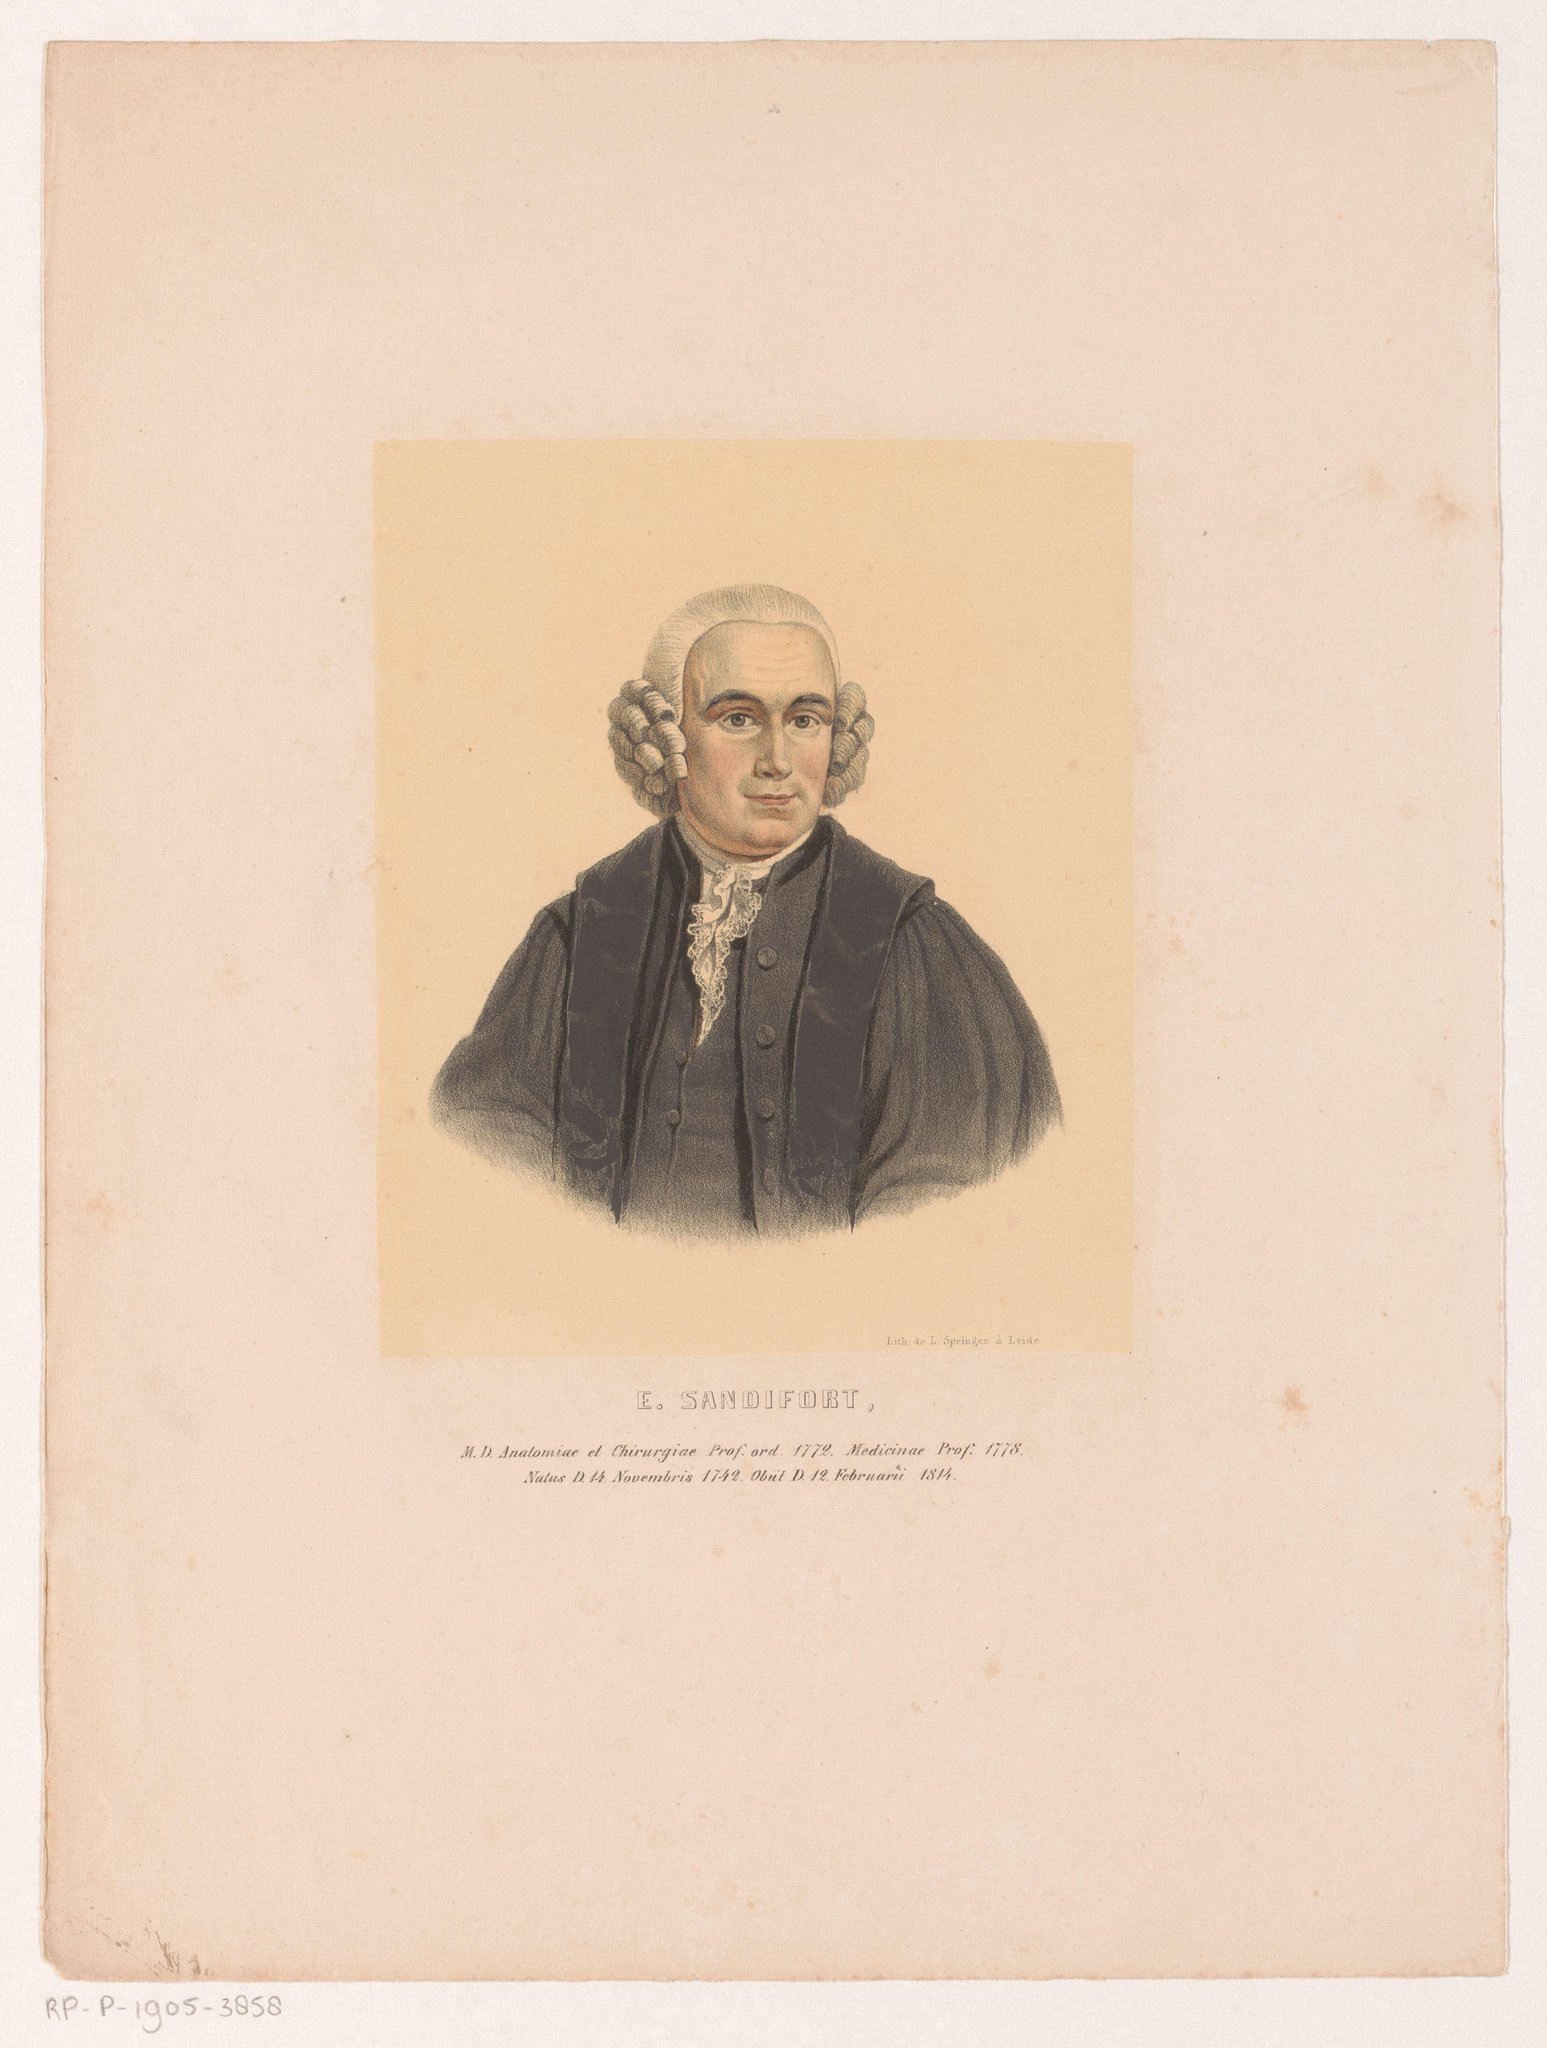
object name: print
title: E. Sandifort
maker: leendert springer (i)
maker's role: draughtsman, painter, print maker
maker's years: 1789-1871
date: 1850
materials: paper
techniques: lithograph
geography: leiden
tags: dordrecht, leiden, historical persons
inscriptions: collector's mark: Lugt 2228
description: Prent uit: Springer, Leendert. Galerij van hoogleeraren aan de Hoogeschool te Leijden, naar de oorspronkelijke afbeeldsels op de Senaat-zaal aldaar berustende. Leiden: Springer, Leendert., s.a. [circa 1850].